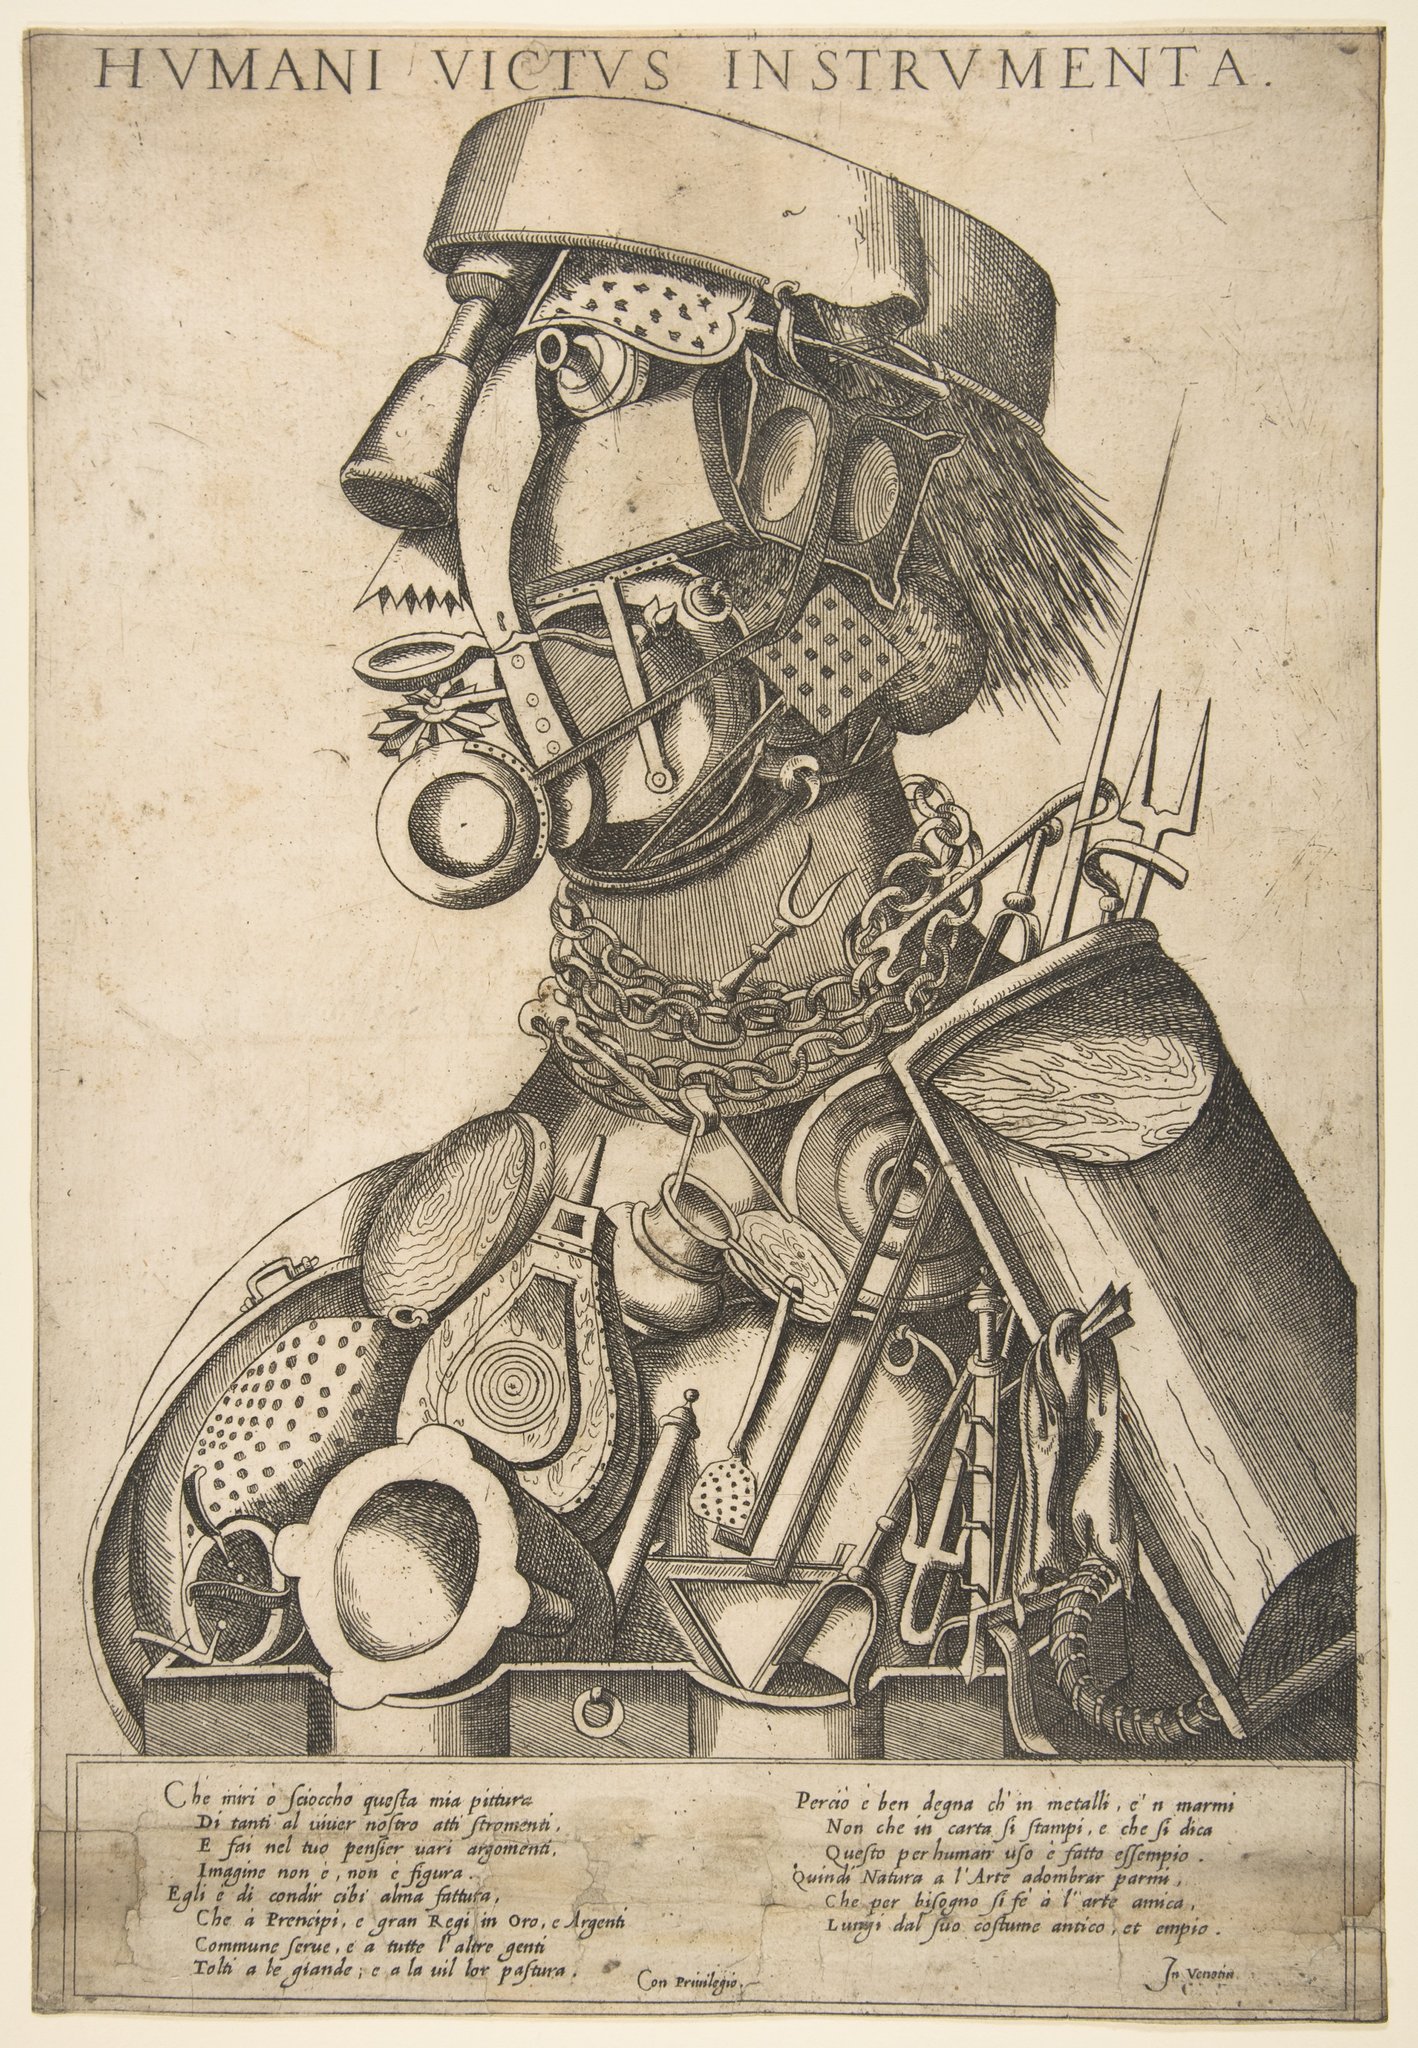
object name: print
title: The Instruments of Human Sustenance (Humani Victus Instrumenta): Cooking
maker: giuseppe arcimboldo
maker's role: artist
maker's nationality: italian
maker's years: 1527-1593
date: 1569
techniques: engraving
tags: cooking,caricature,tools